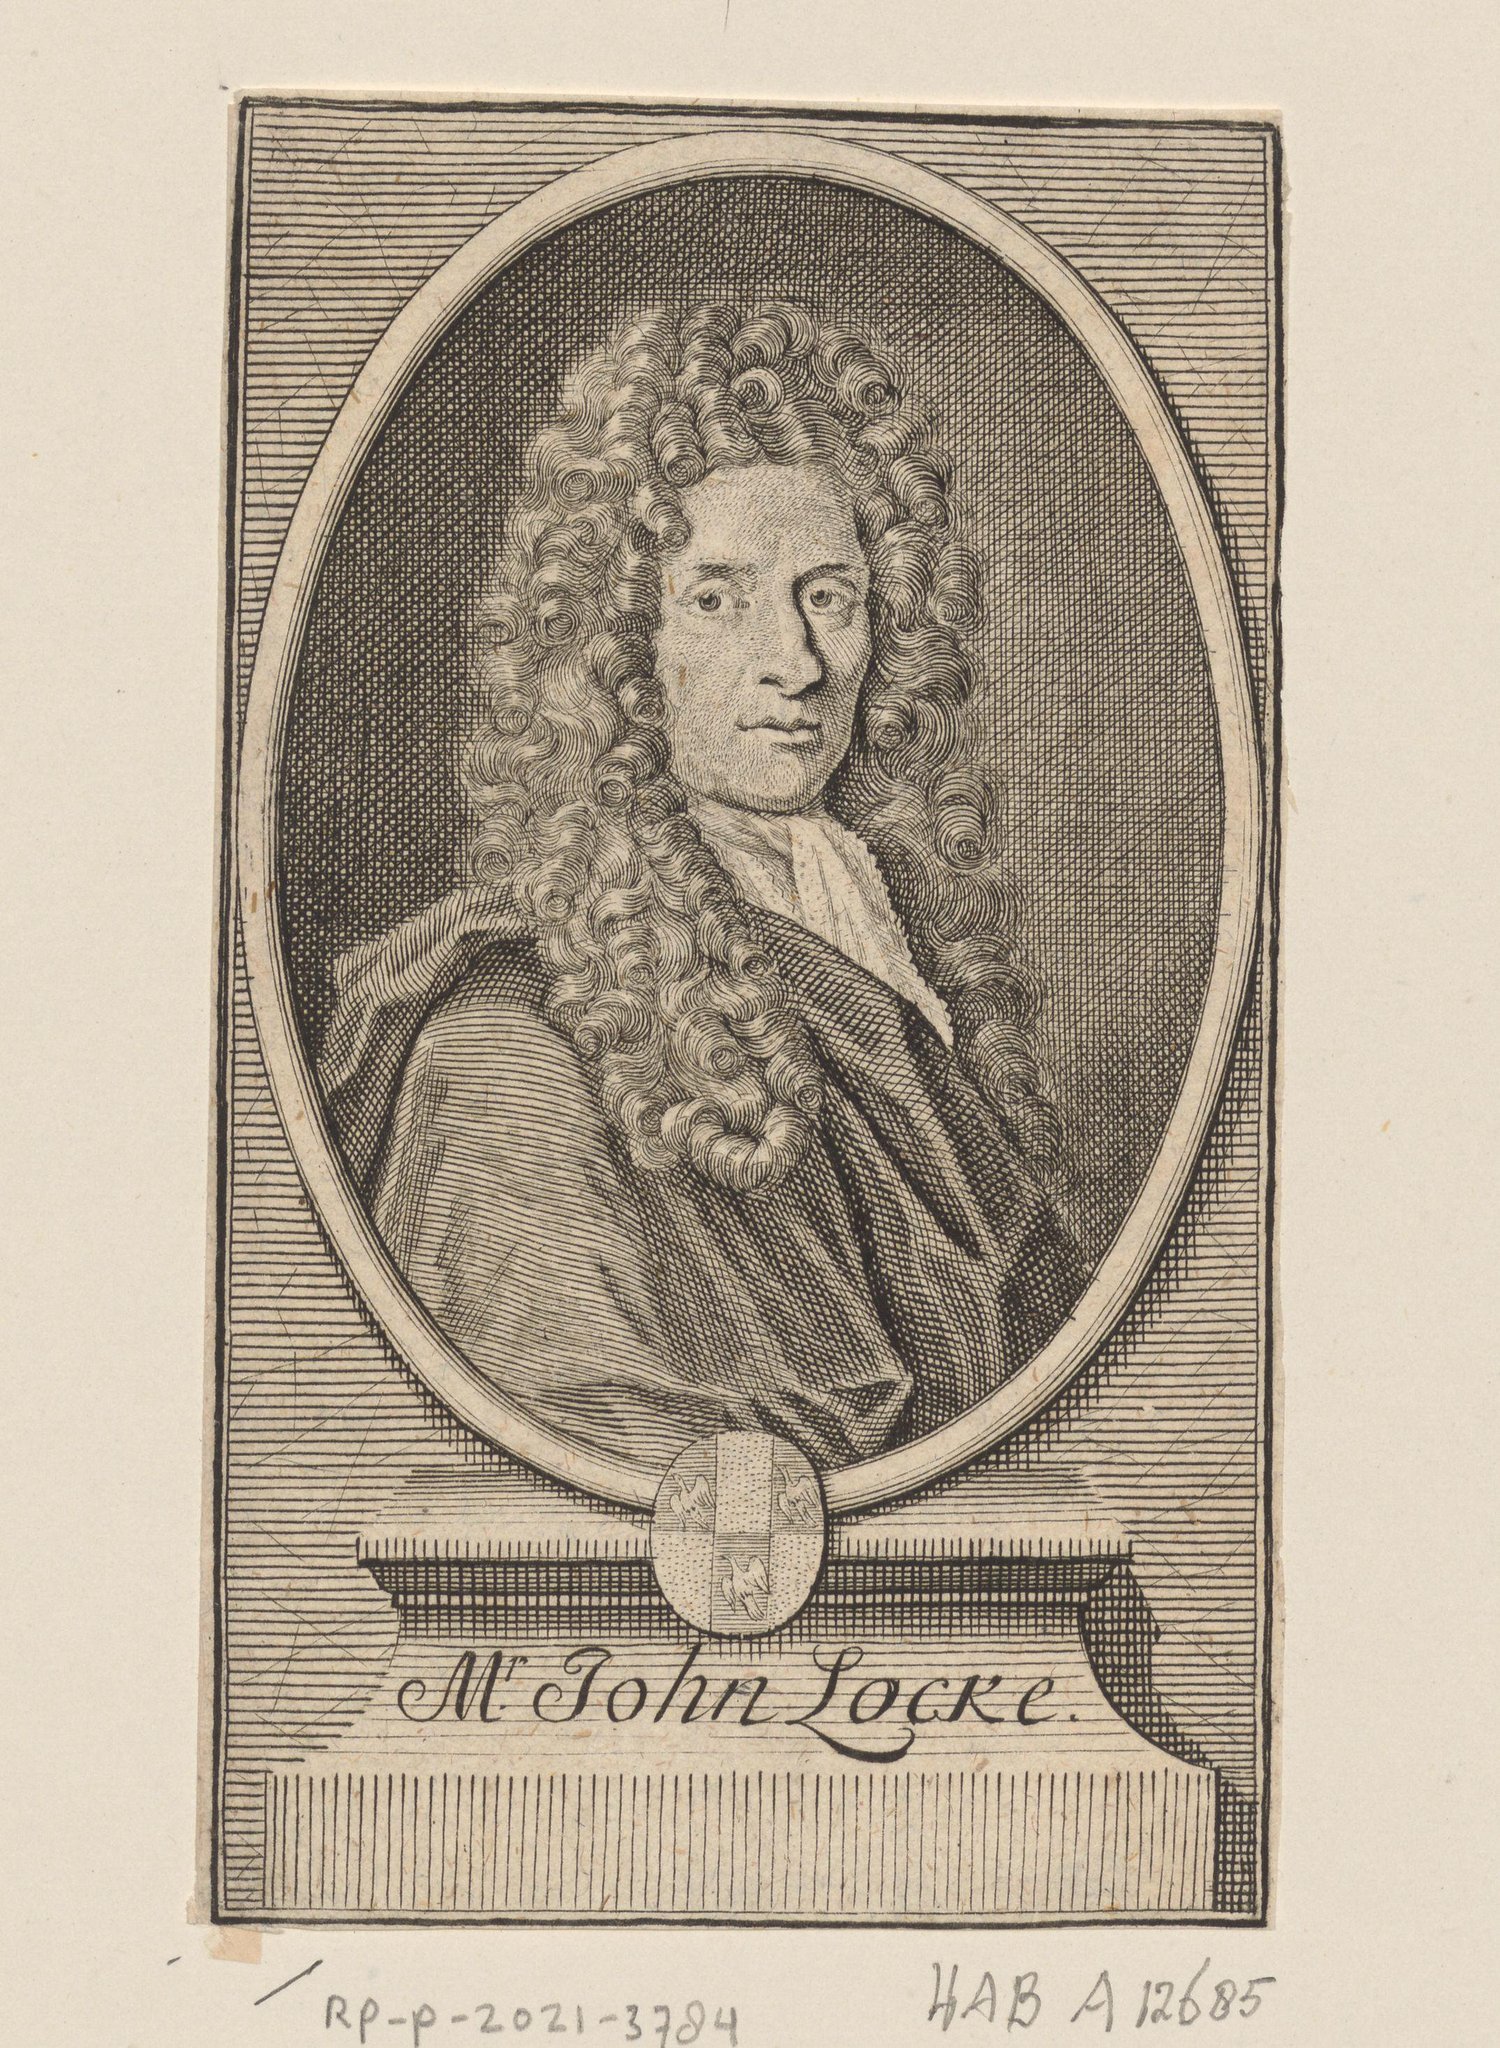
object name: print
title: Portret van John Locke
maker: Anonymous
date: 1700-1799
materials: paper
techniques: engraving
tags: politician, physicist, ornament ~ medallion, historical persons, scholar, philosopher (+ portrait of scholar, scientist), armorial bearing, heraldry